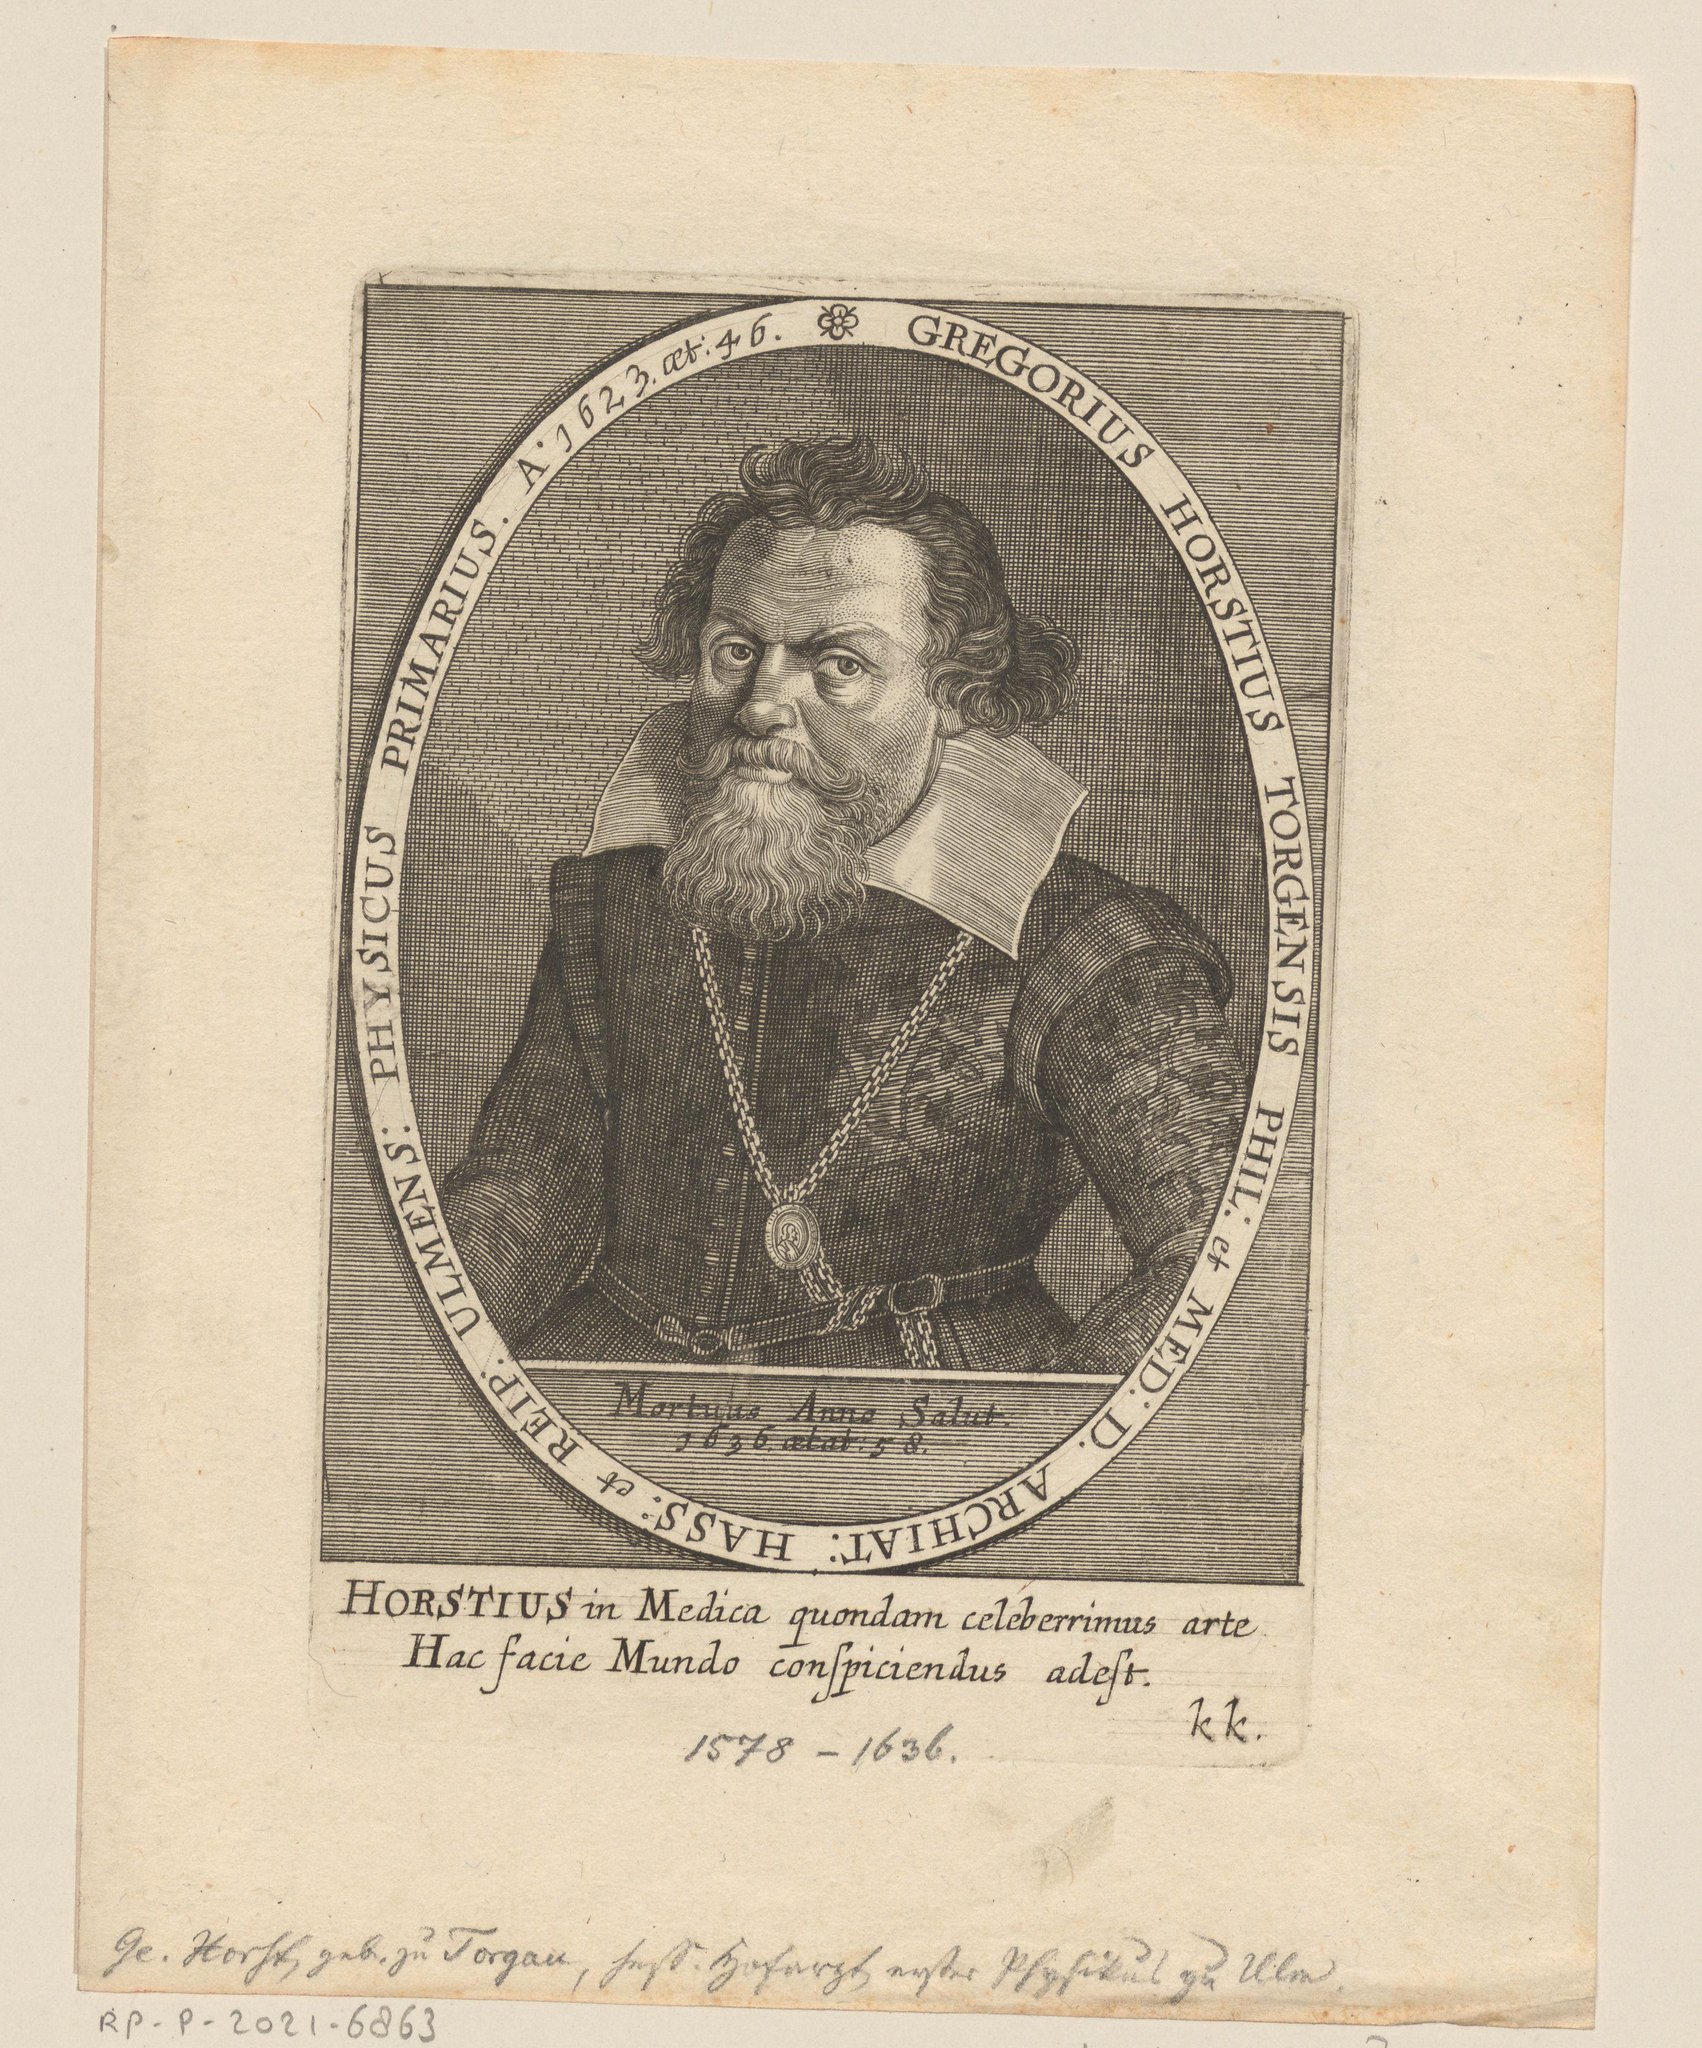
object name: print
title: Portret van Gregor Horst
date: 1650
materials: paper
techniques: engraving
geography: frankfurt am main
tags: historical persons, physician, doctor